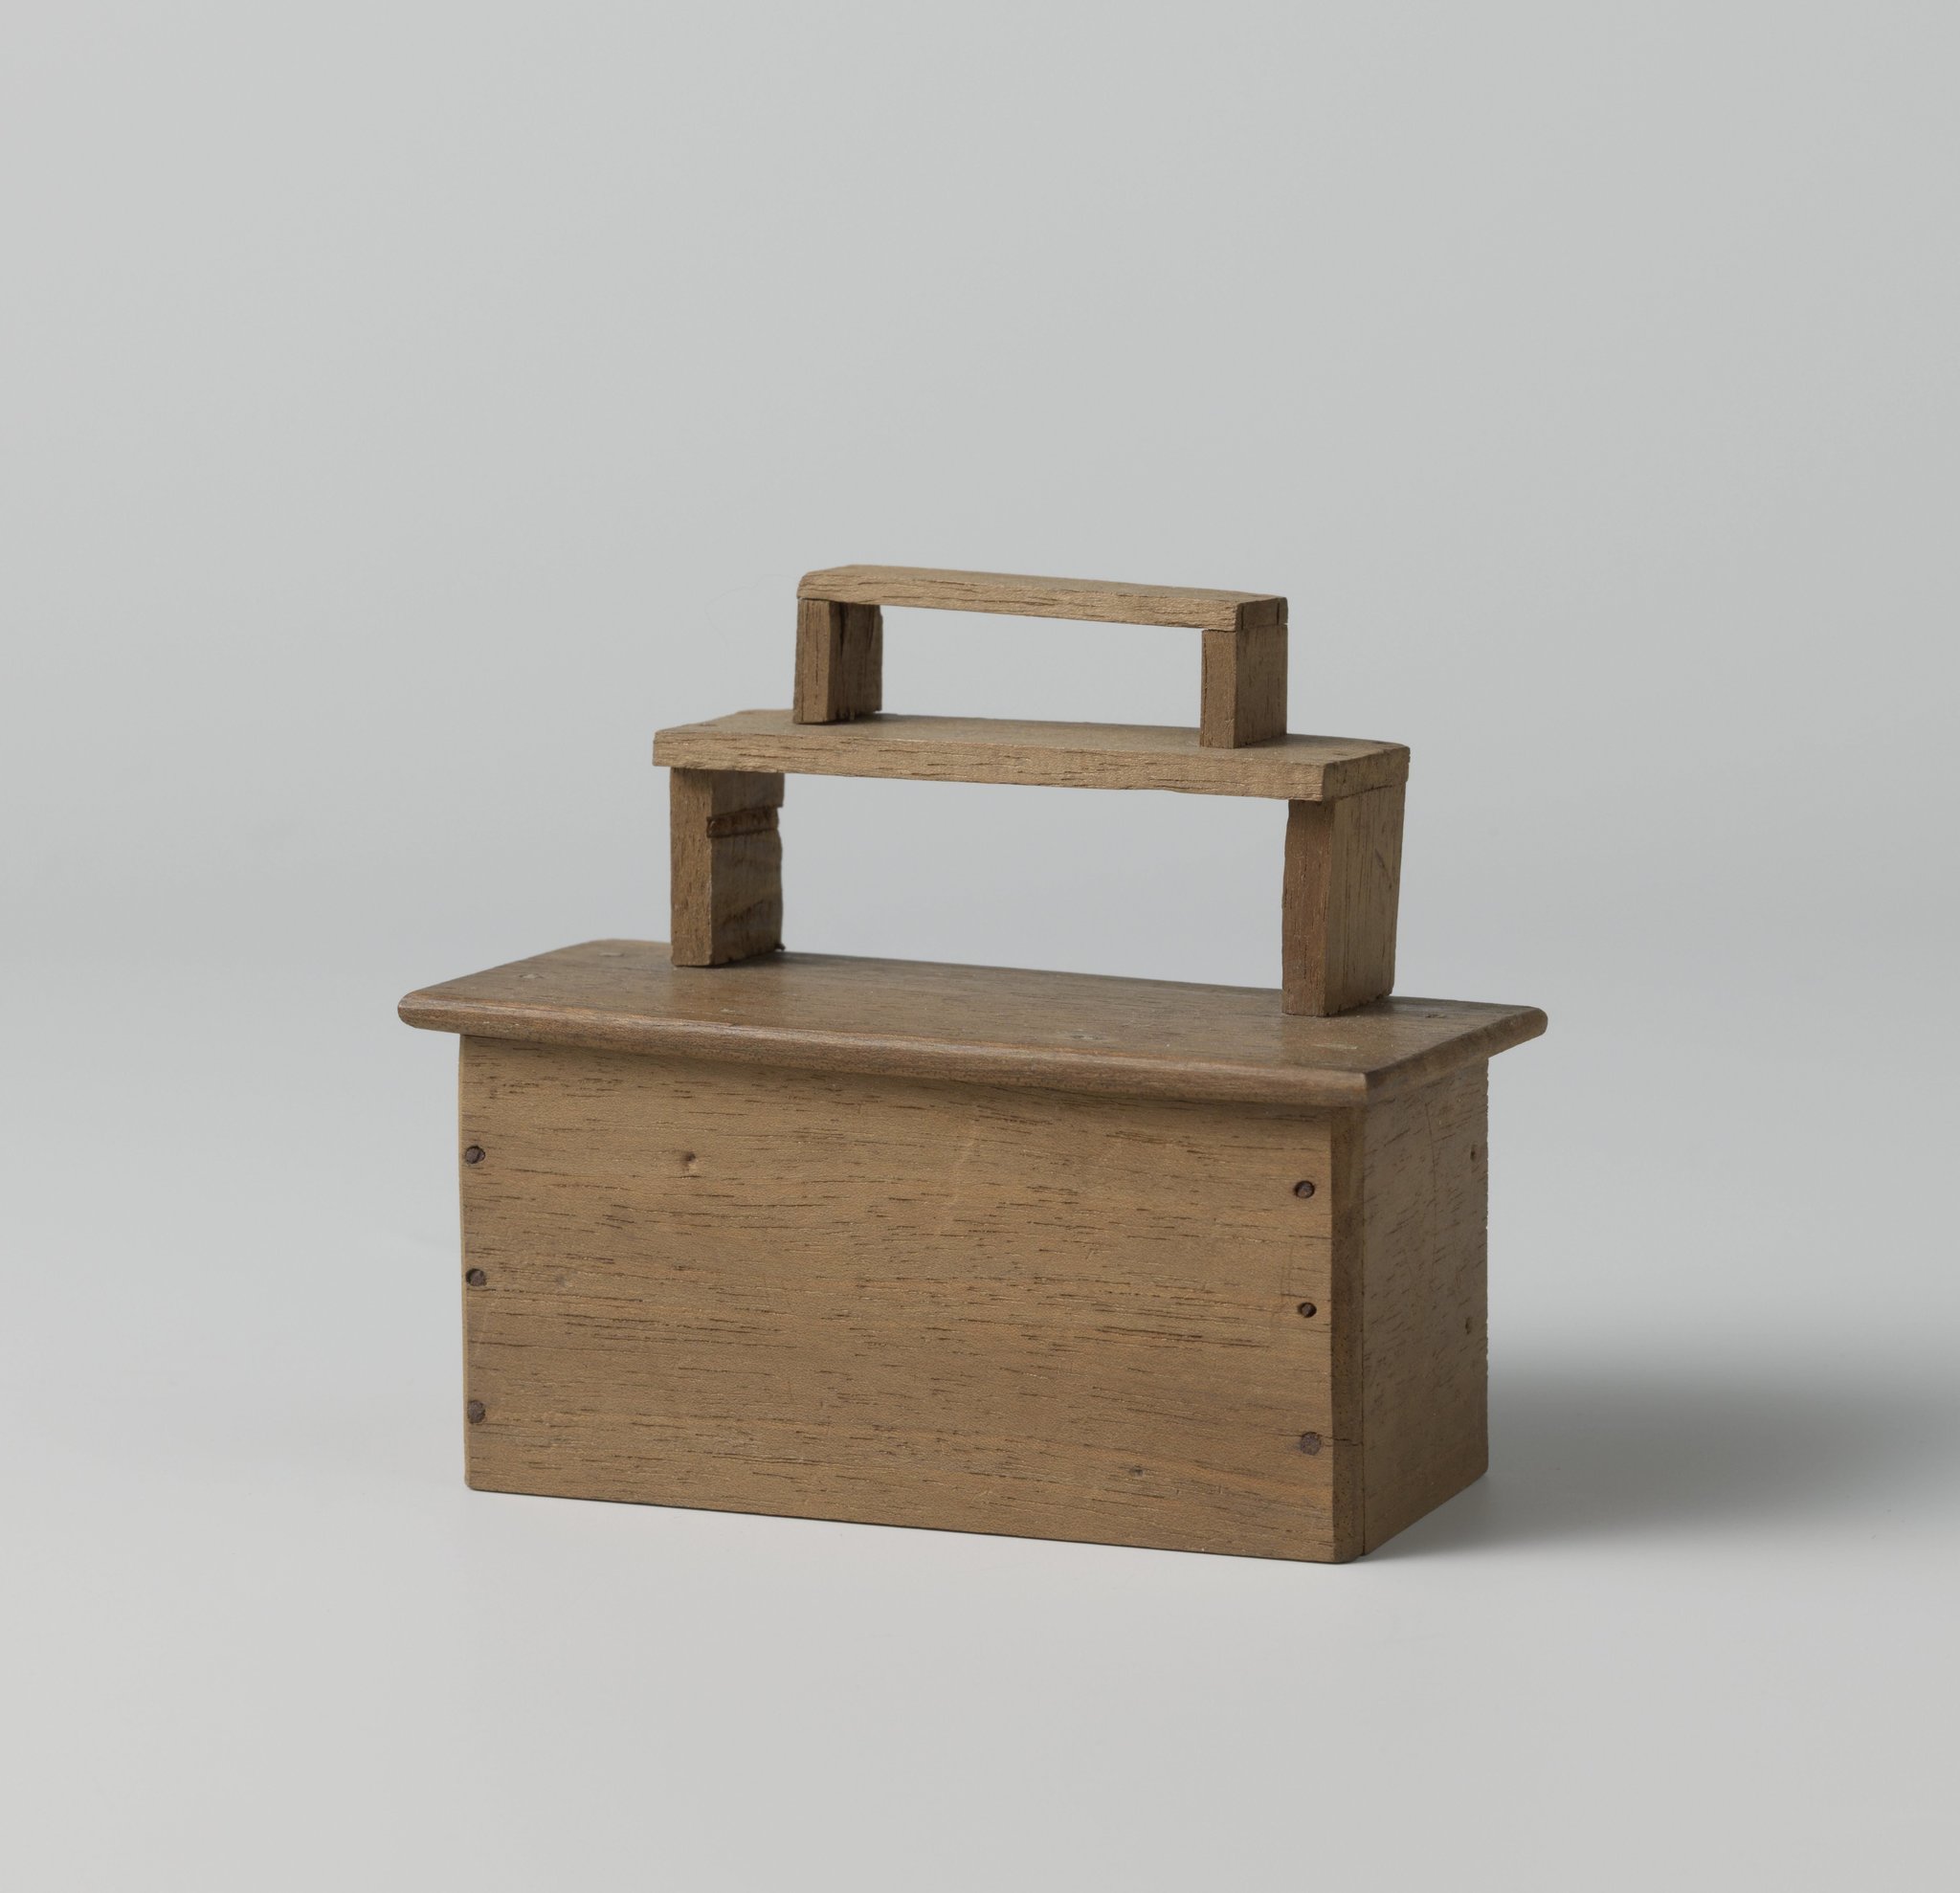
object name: buffet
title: Buffet, bestaande uit een gesloten onderstel waarboven twee planken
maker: Anonymous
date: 1700-1799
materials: wood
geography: amsterdam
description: Een buffet van notenhout, bestaande uit kistvormig onderstel zonder bodem en achterkant; waarop kleine stellage van twee planken, waarvan de bovenste korter en smaller.